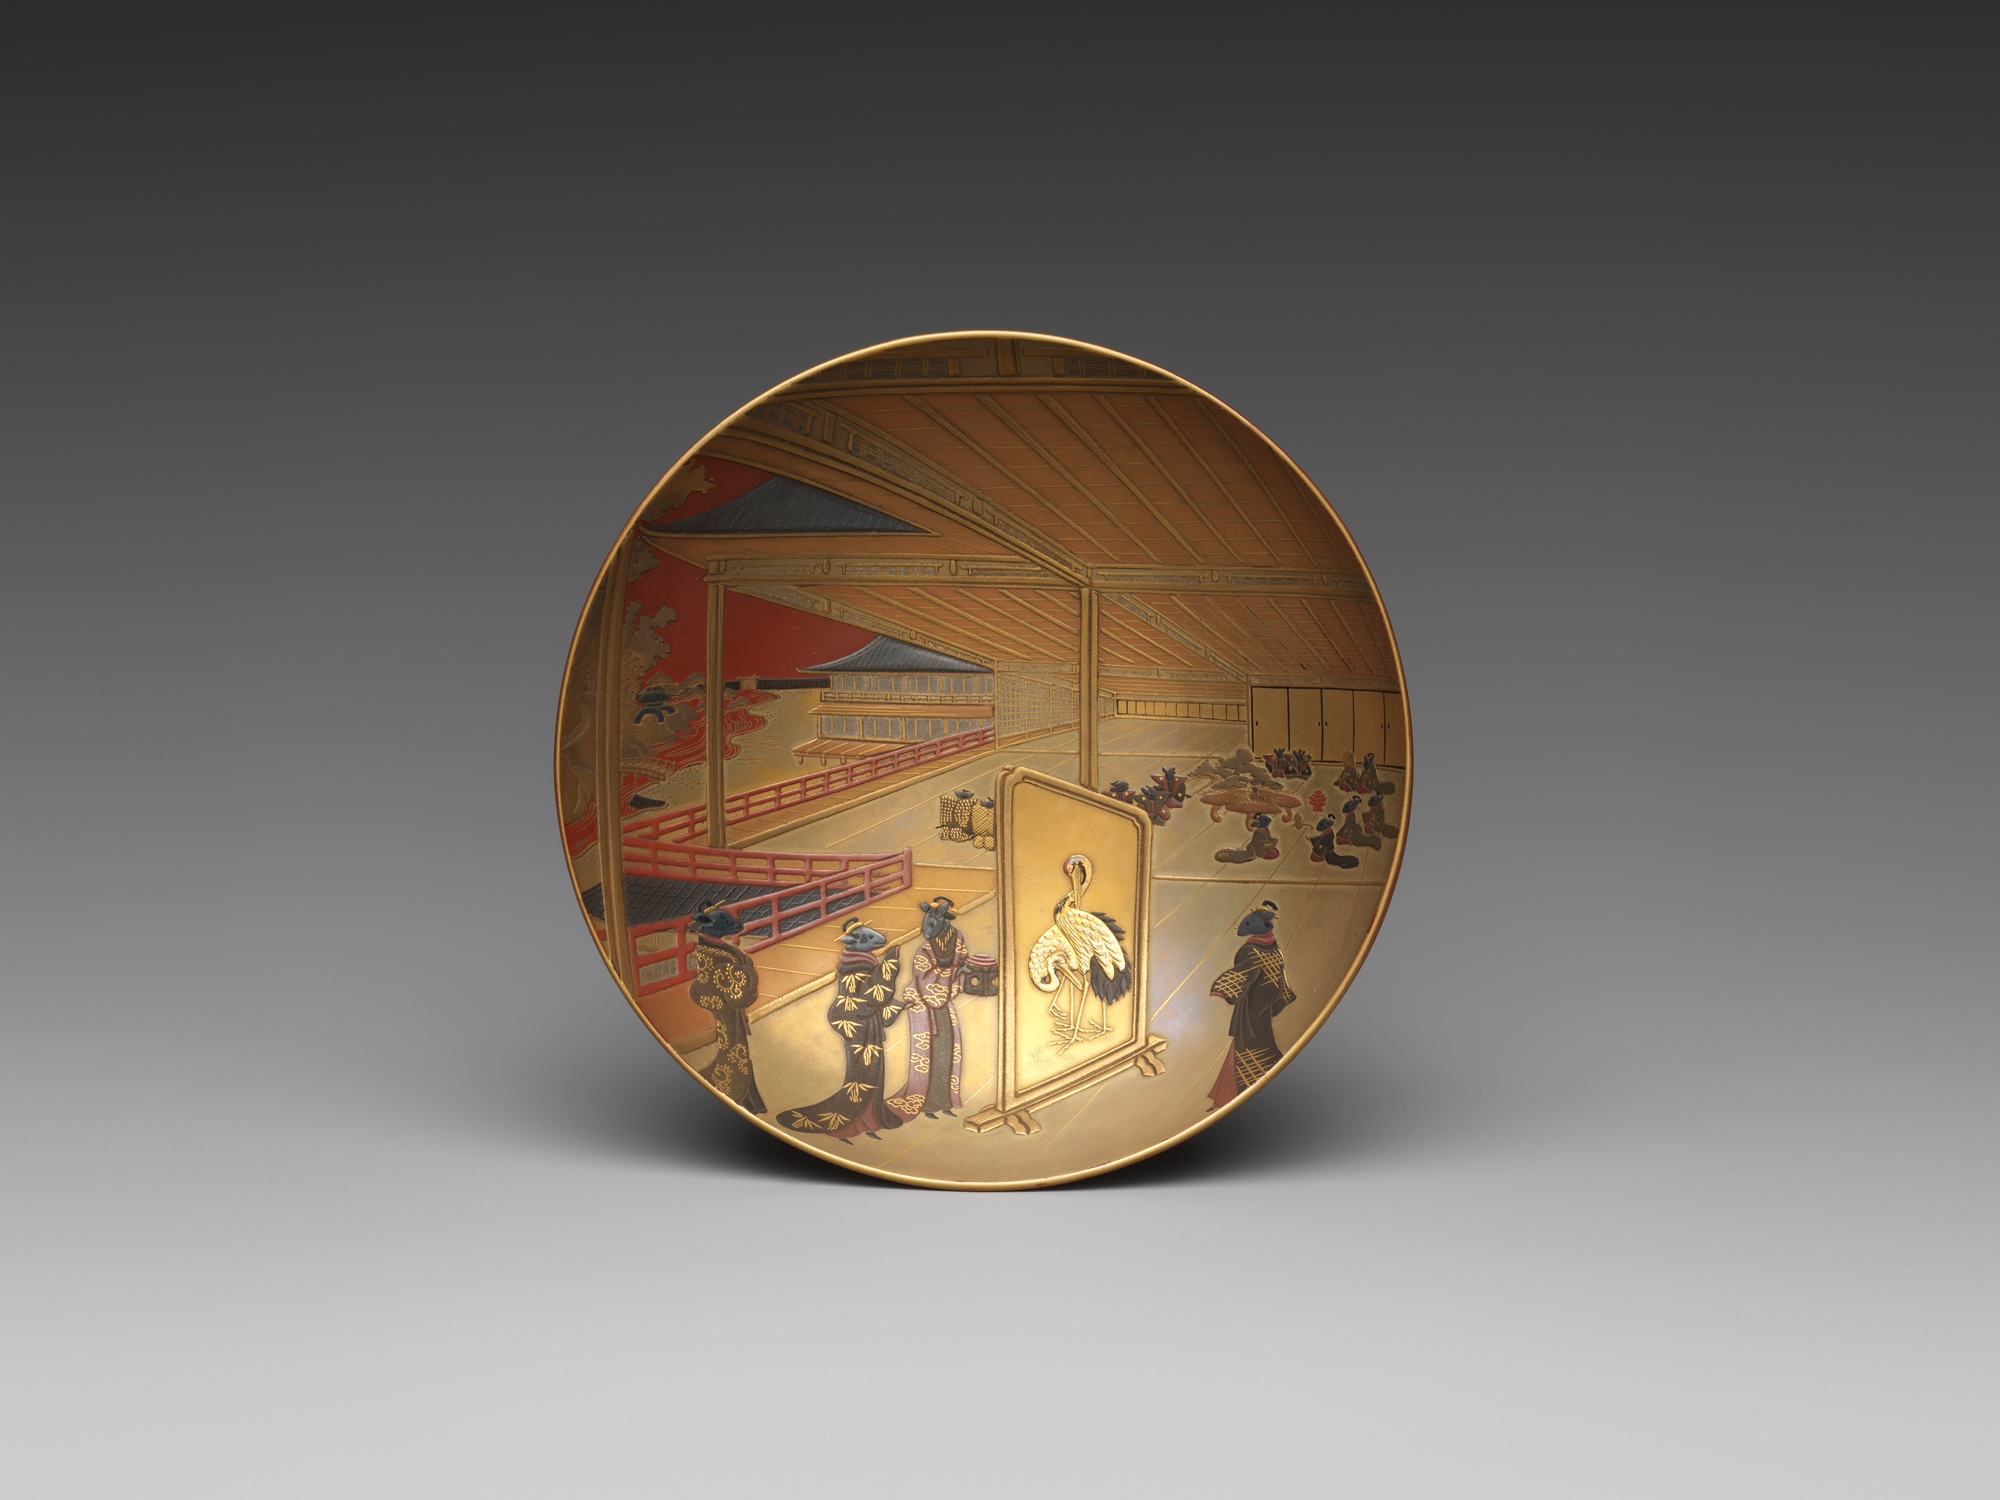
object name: wine cup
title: One of a Pair of Wine Cups (Sakazuki) with Mice’s Wedding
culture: japanese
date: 1801-1900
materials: gold, gold foil, lacquer, silver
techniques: maki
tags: cranes,mythical creatures,mice,weddings